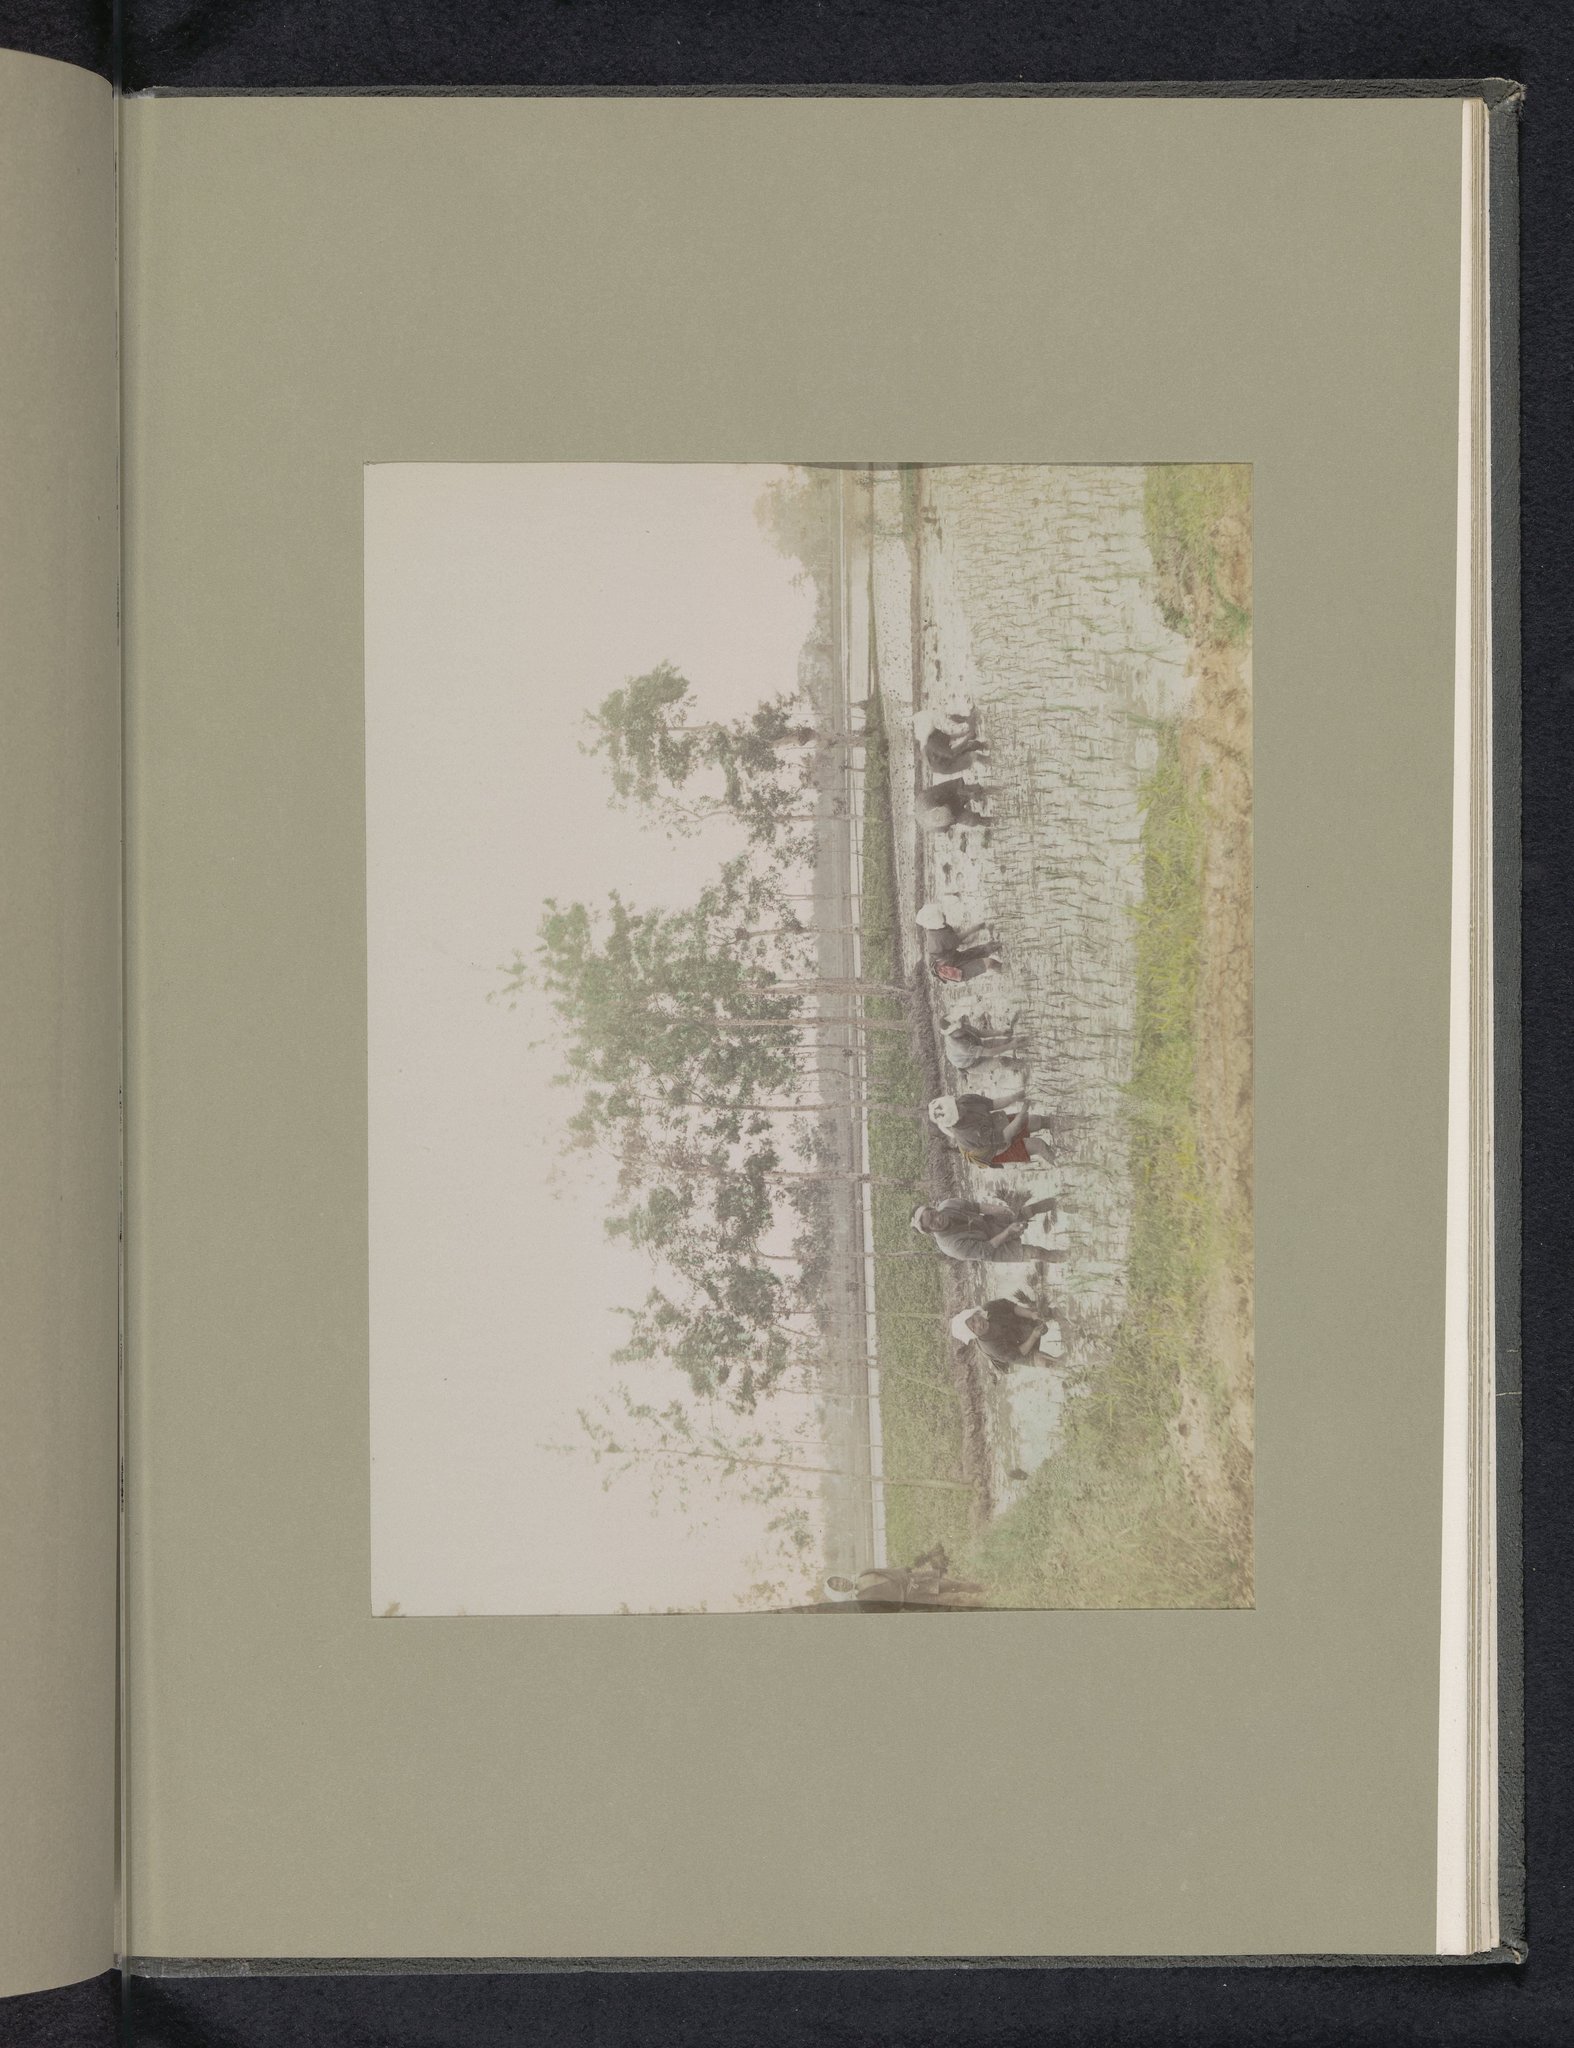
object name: page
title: Boeren planten rijst in een rijstveld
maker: Anonymous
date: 1887-1897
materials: photographic support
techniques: albumen print, hand coloring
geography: japan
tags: farmers, sawahs, rice paddies